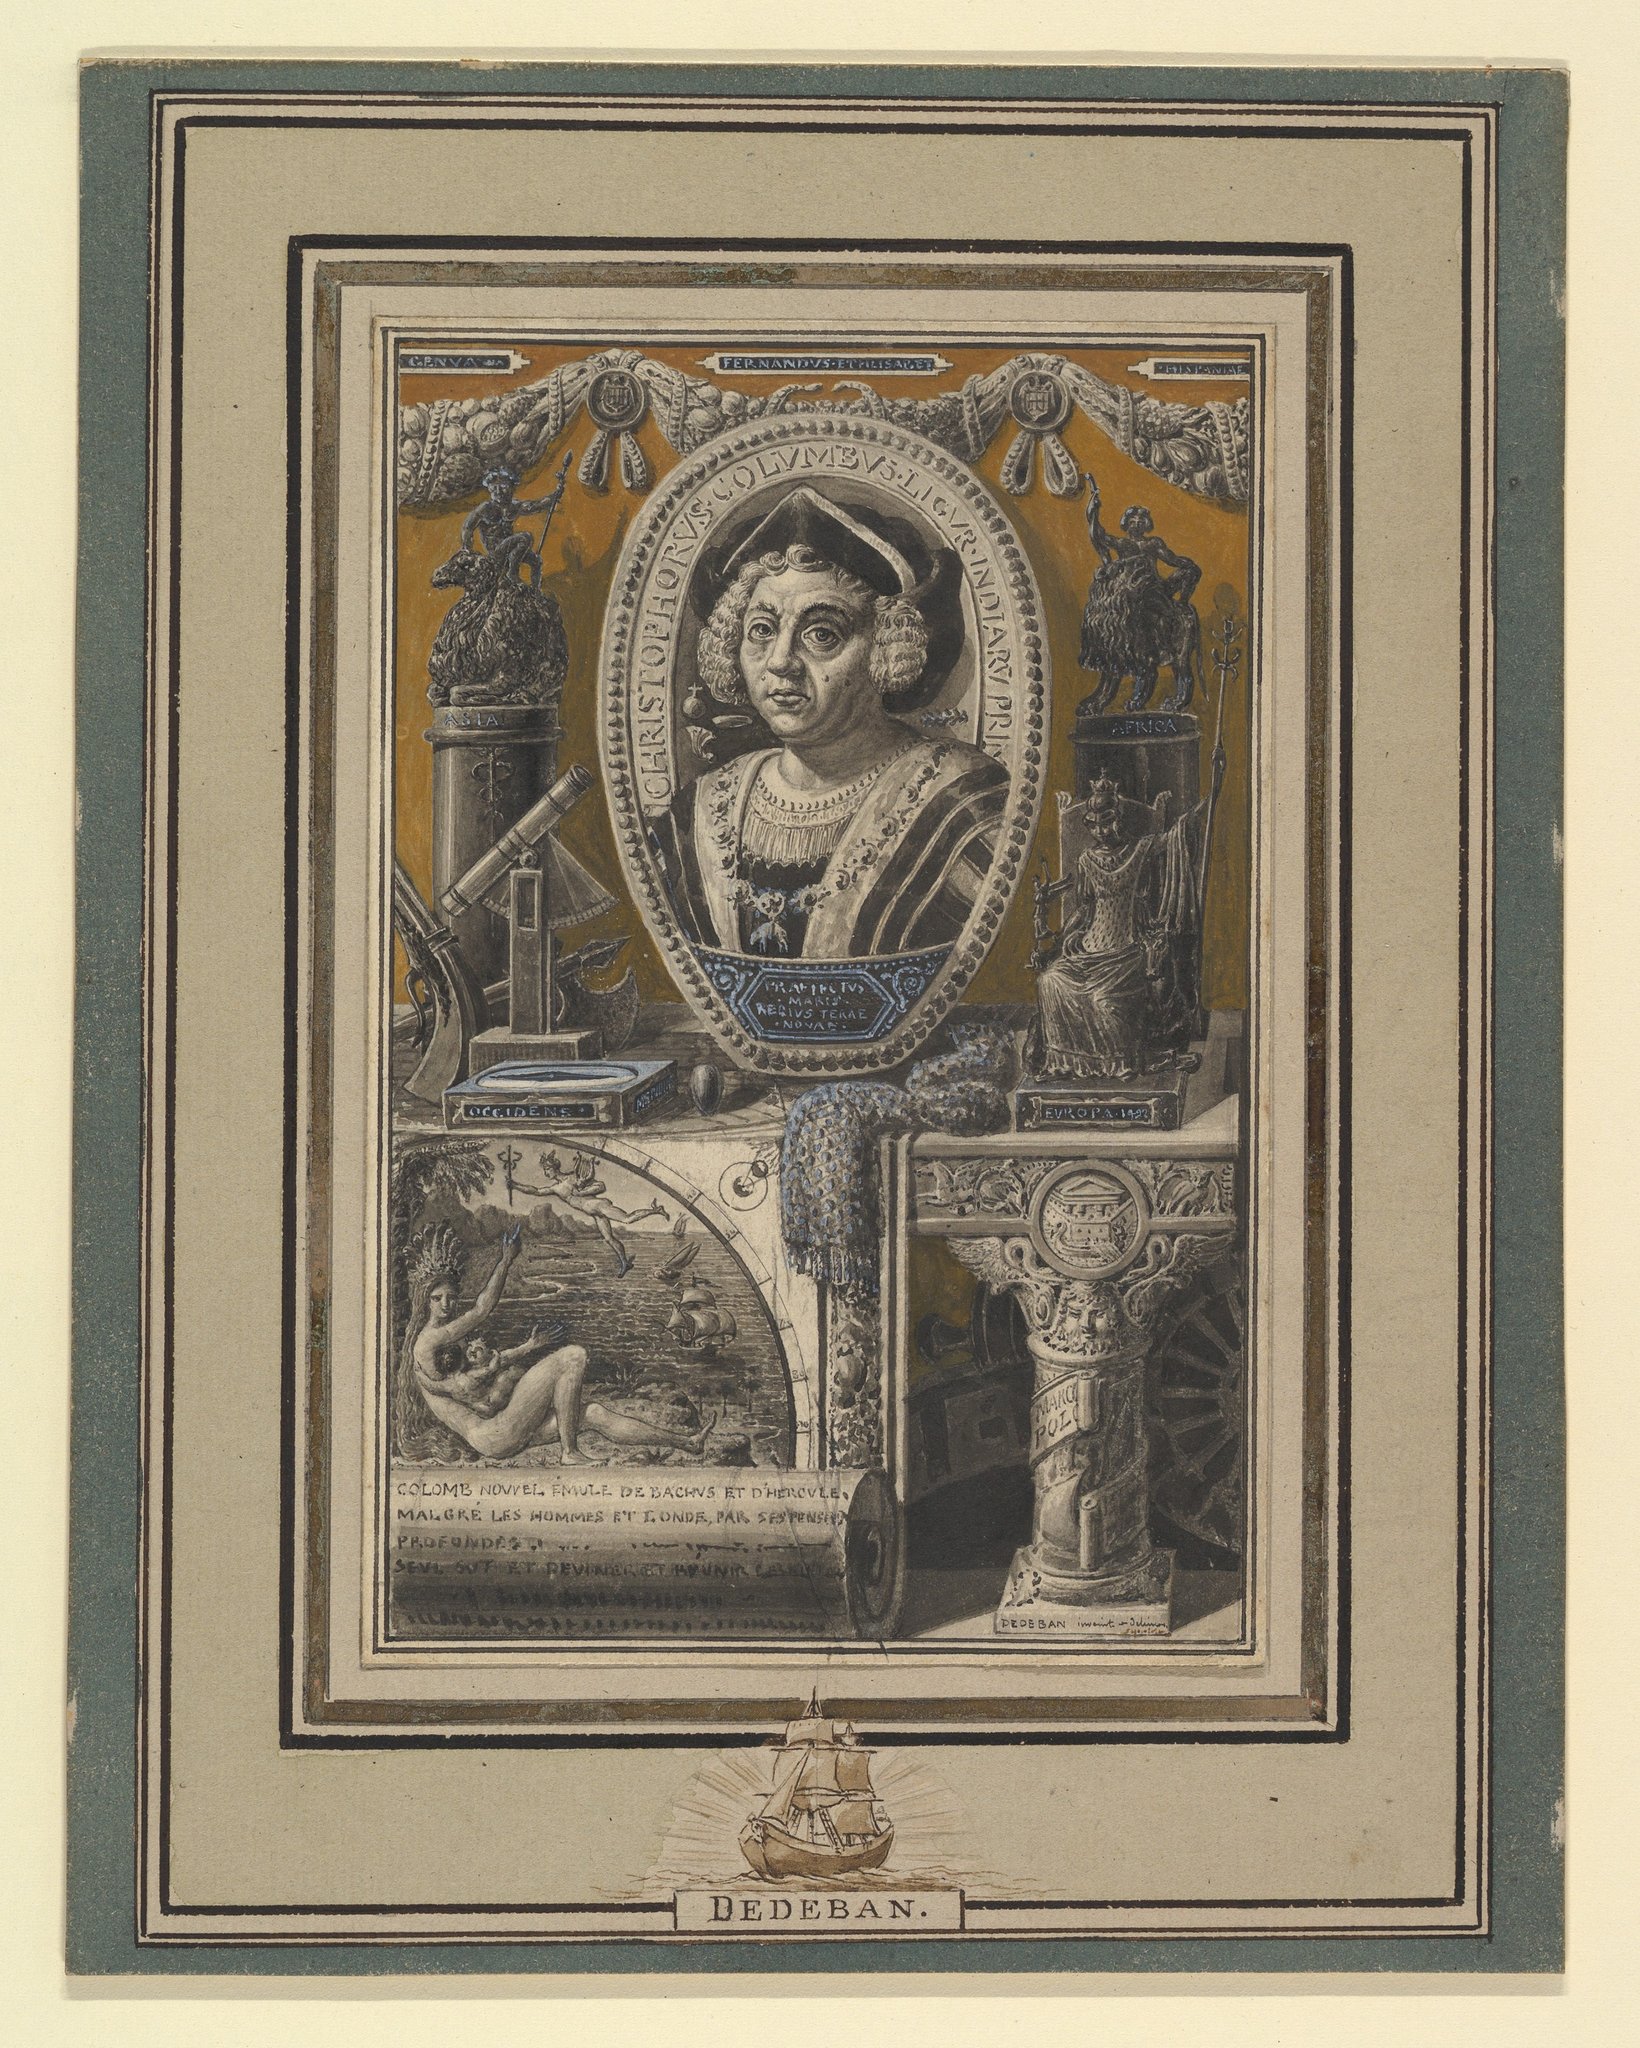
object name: drawing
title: Christopher Columbus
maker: jean-baptiste dedéban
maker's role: artist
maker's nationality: french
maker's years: 1781-1849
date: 1805-1849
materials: gouache, ink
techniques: heightening, pen, wash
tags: christopher columbus,infants,portraits,female nudes